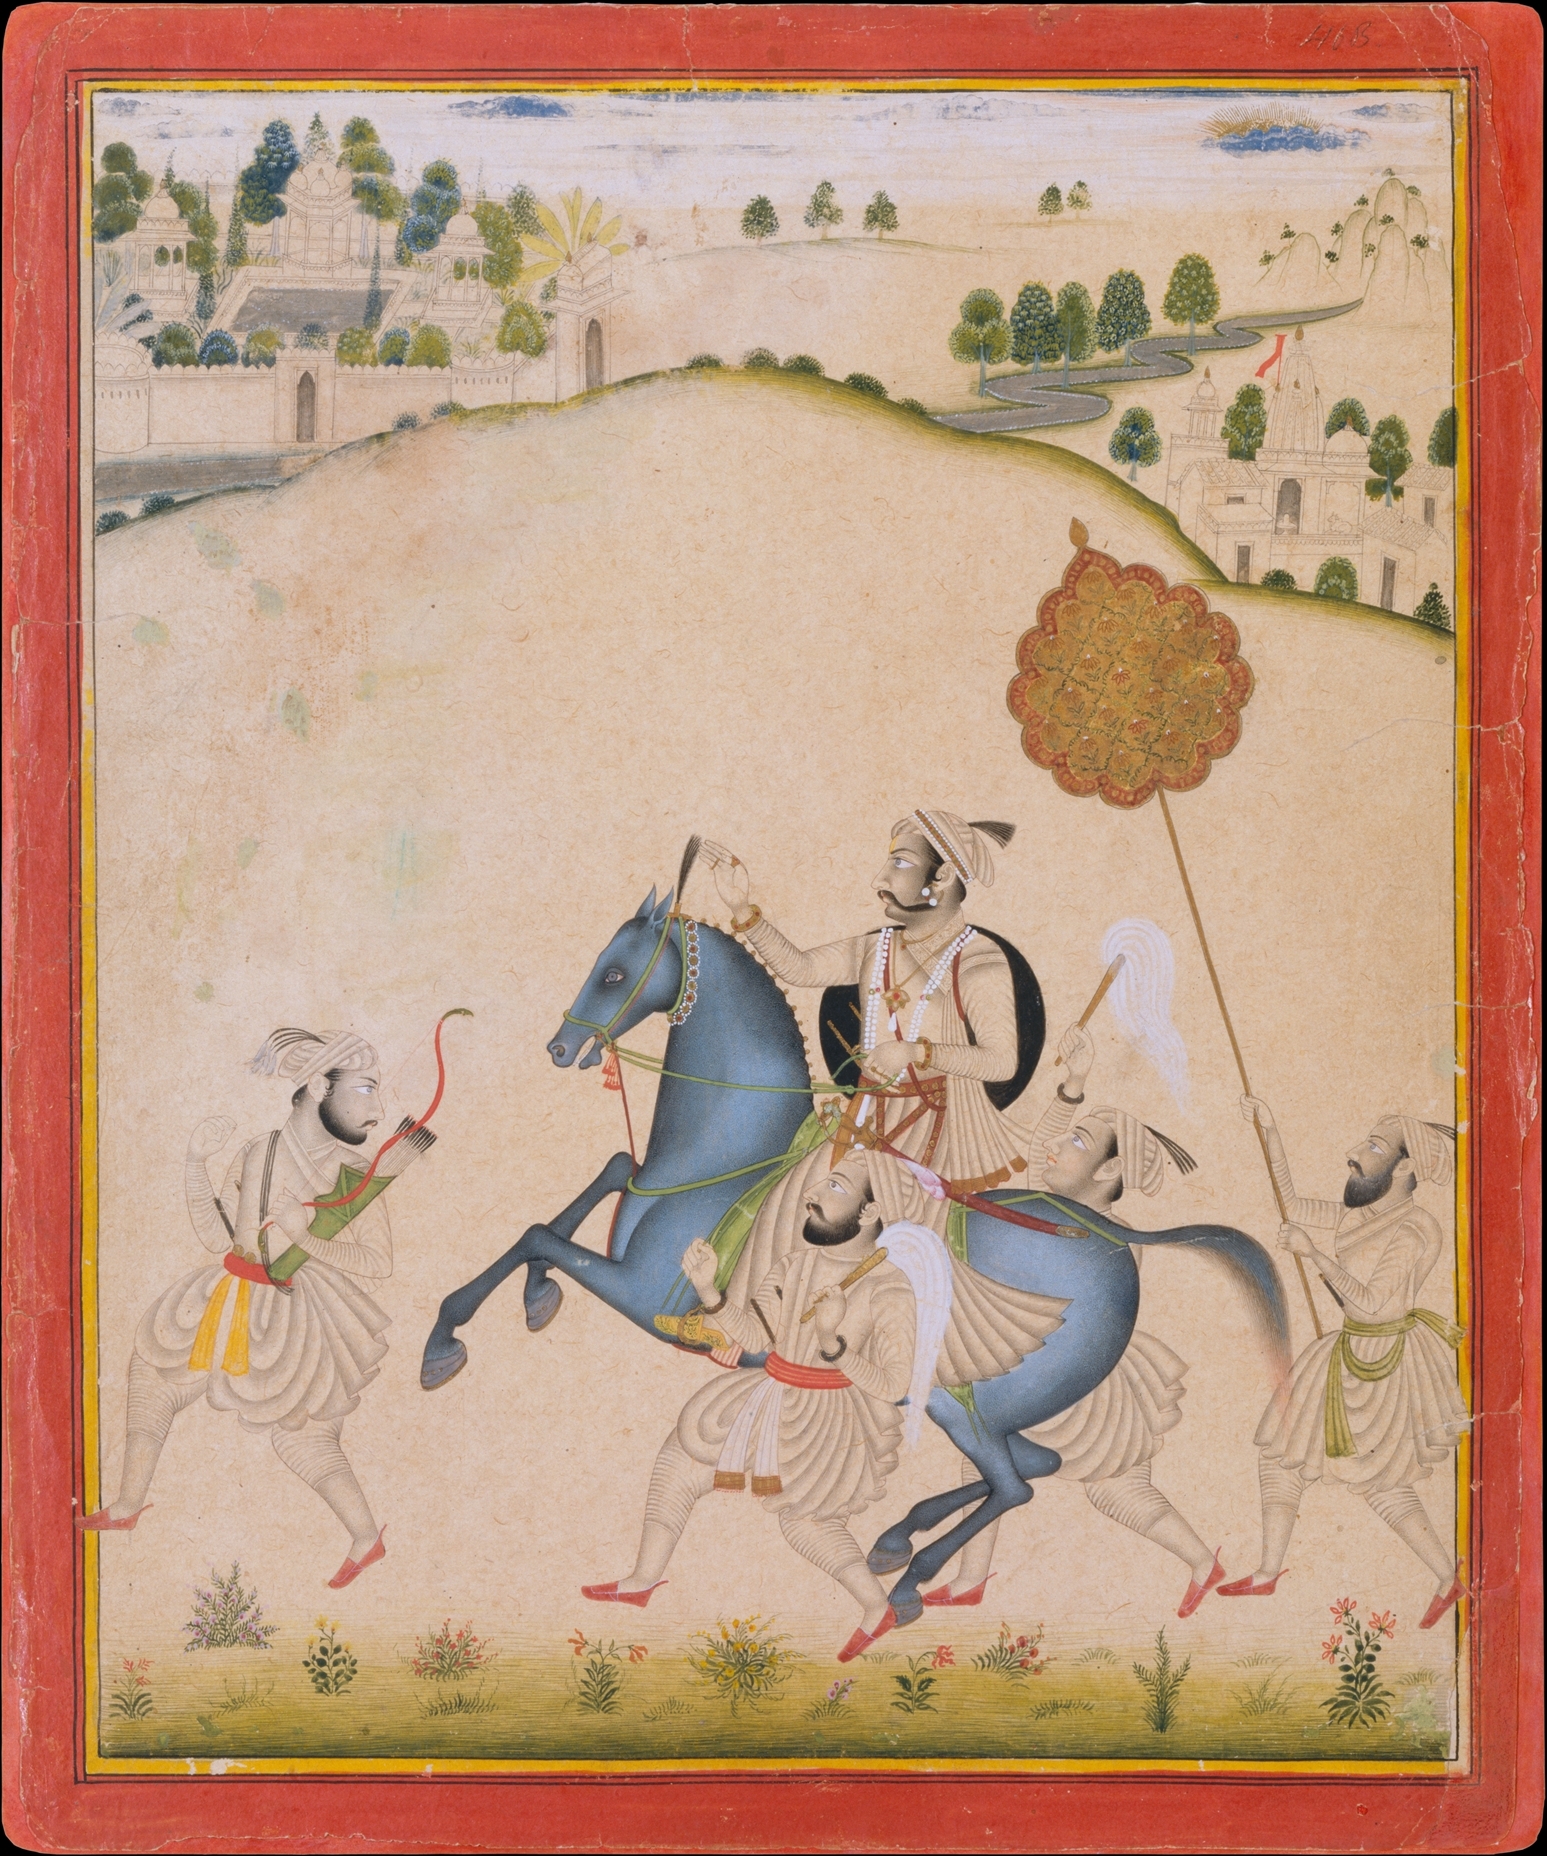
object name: painting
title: Maharana Amar Singh II Riding a Jodhpur Horse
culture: western indian, rajasthan, udaipur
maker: stipple master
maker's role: artist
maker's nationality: indian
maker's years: 1680-1725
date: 1700-1710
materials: ink, paper, watercolor